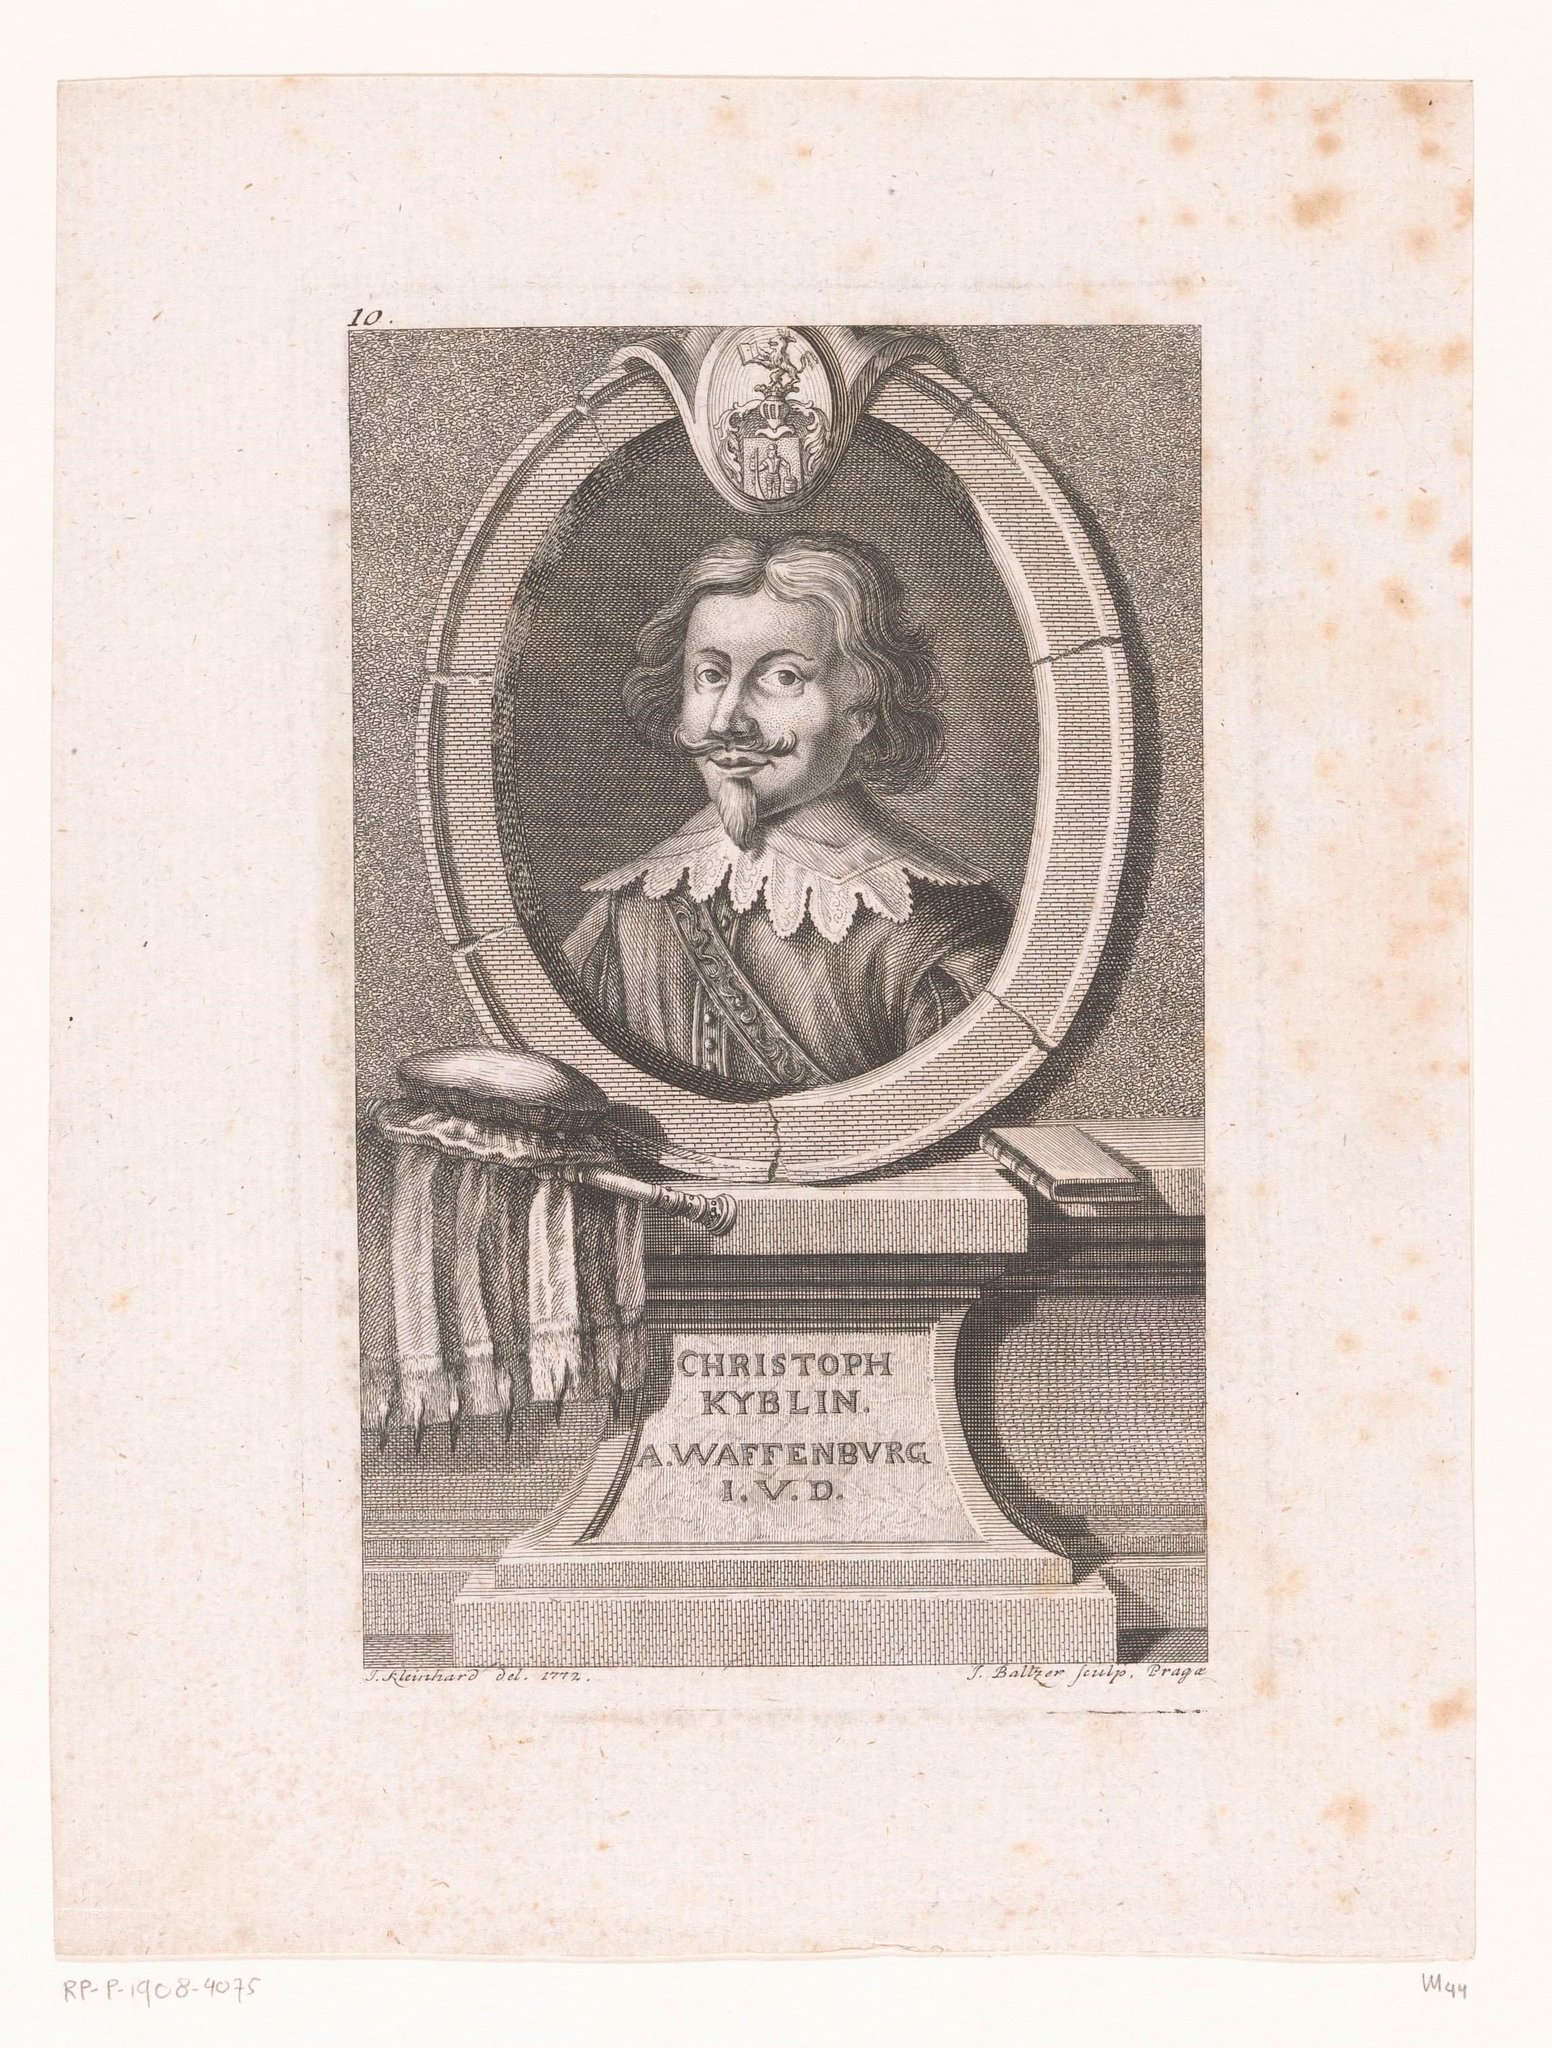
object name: print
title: Christoph Kyblin. A. Waffenburg I.U.D.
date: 1772-1799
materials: paper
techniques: engraving, etching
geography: prague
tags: prague, historical persons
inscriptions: collector's mark: Lugt 2228